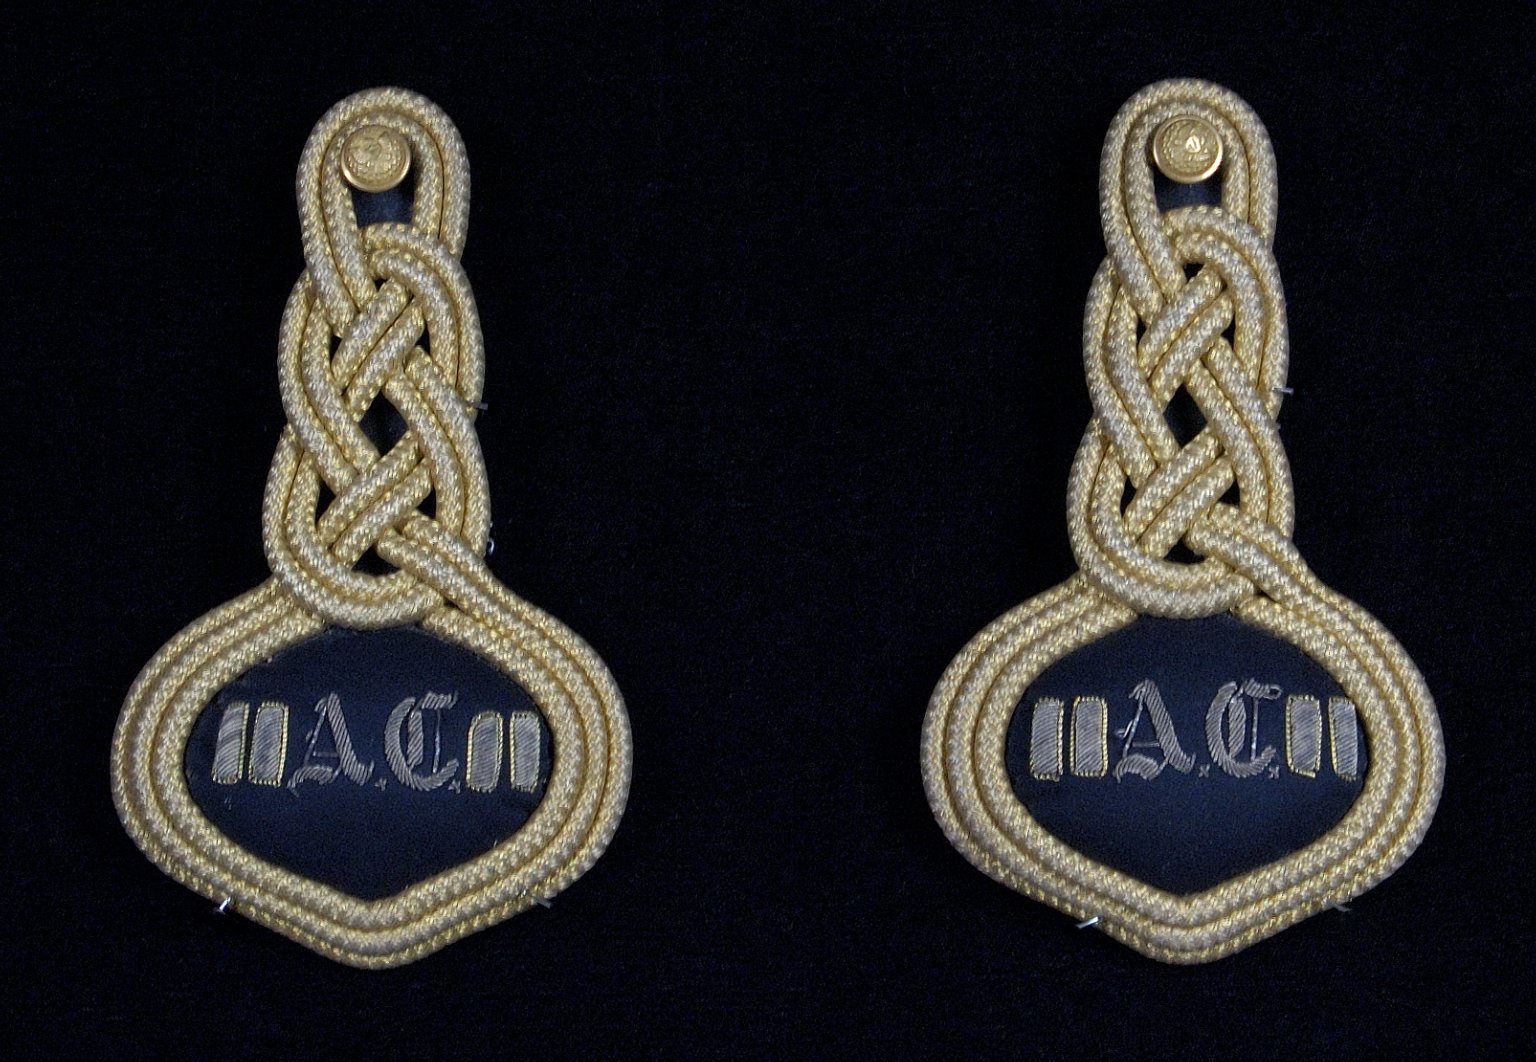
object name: military epaulet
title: Military Epaulets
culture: american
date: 1875-1880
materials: wool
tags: army